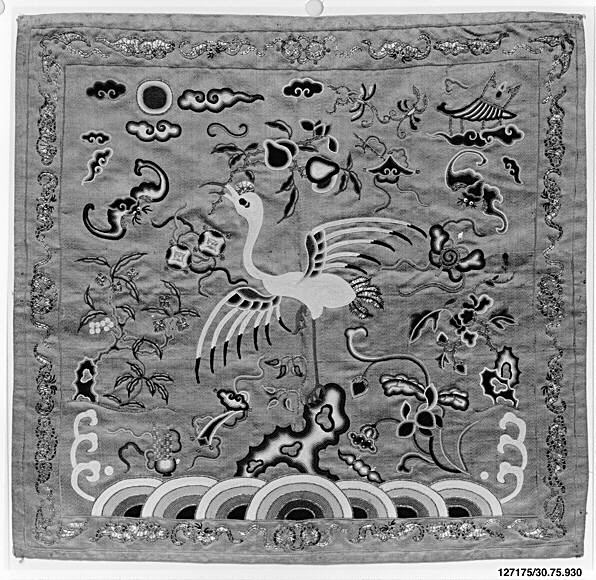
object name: rank badge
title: Rank Badge with Manchurian Crane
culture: chinese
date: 1701-1733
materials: metal thread, silk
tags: bats,cranes